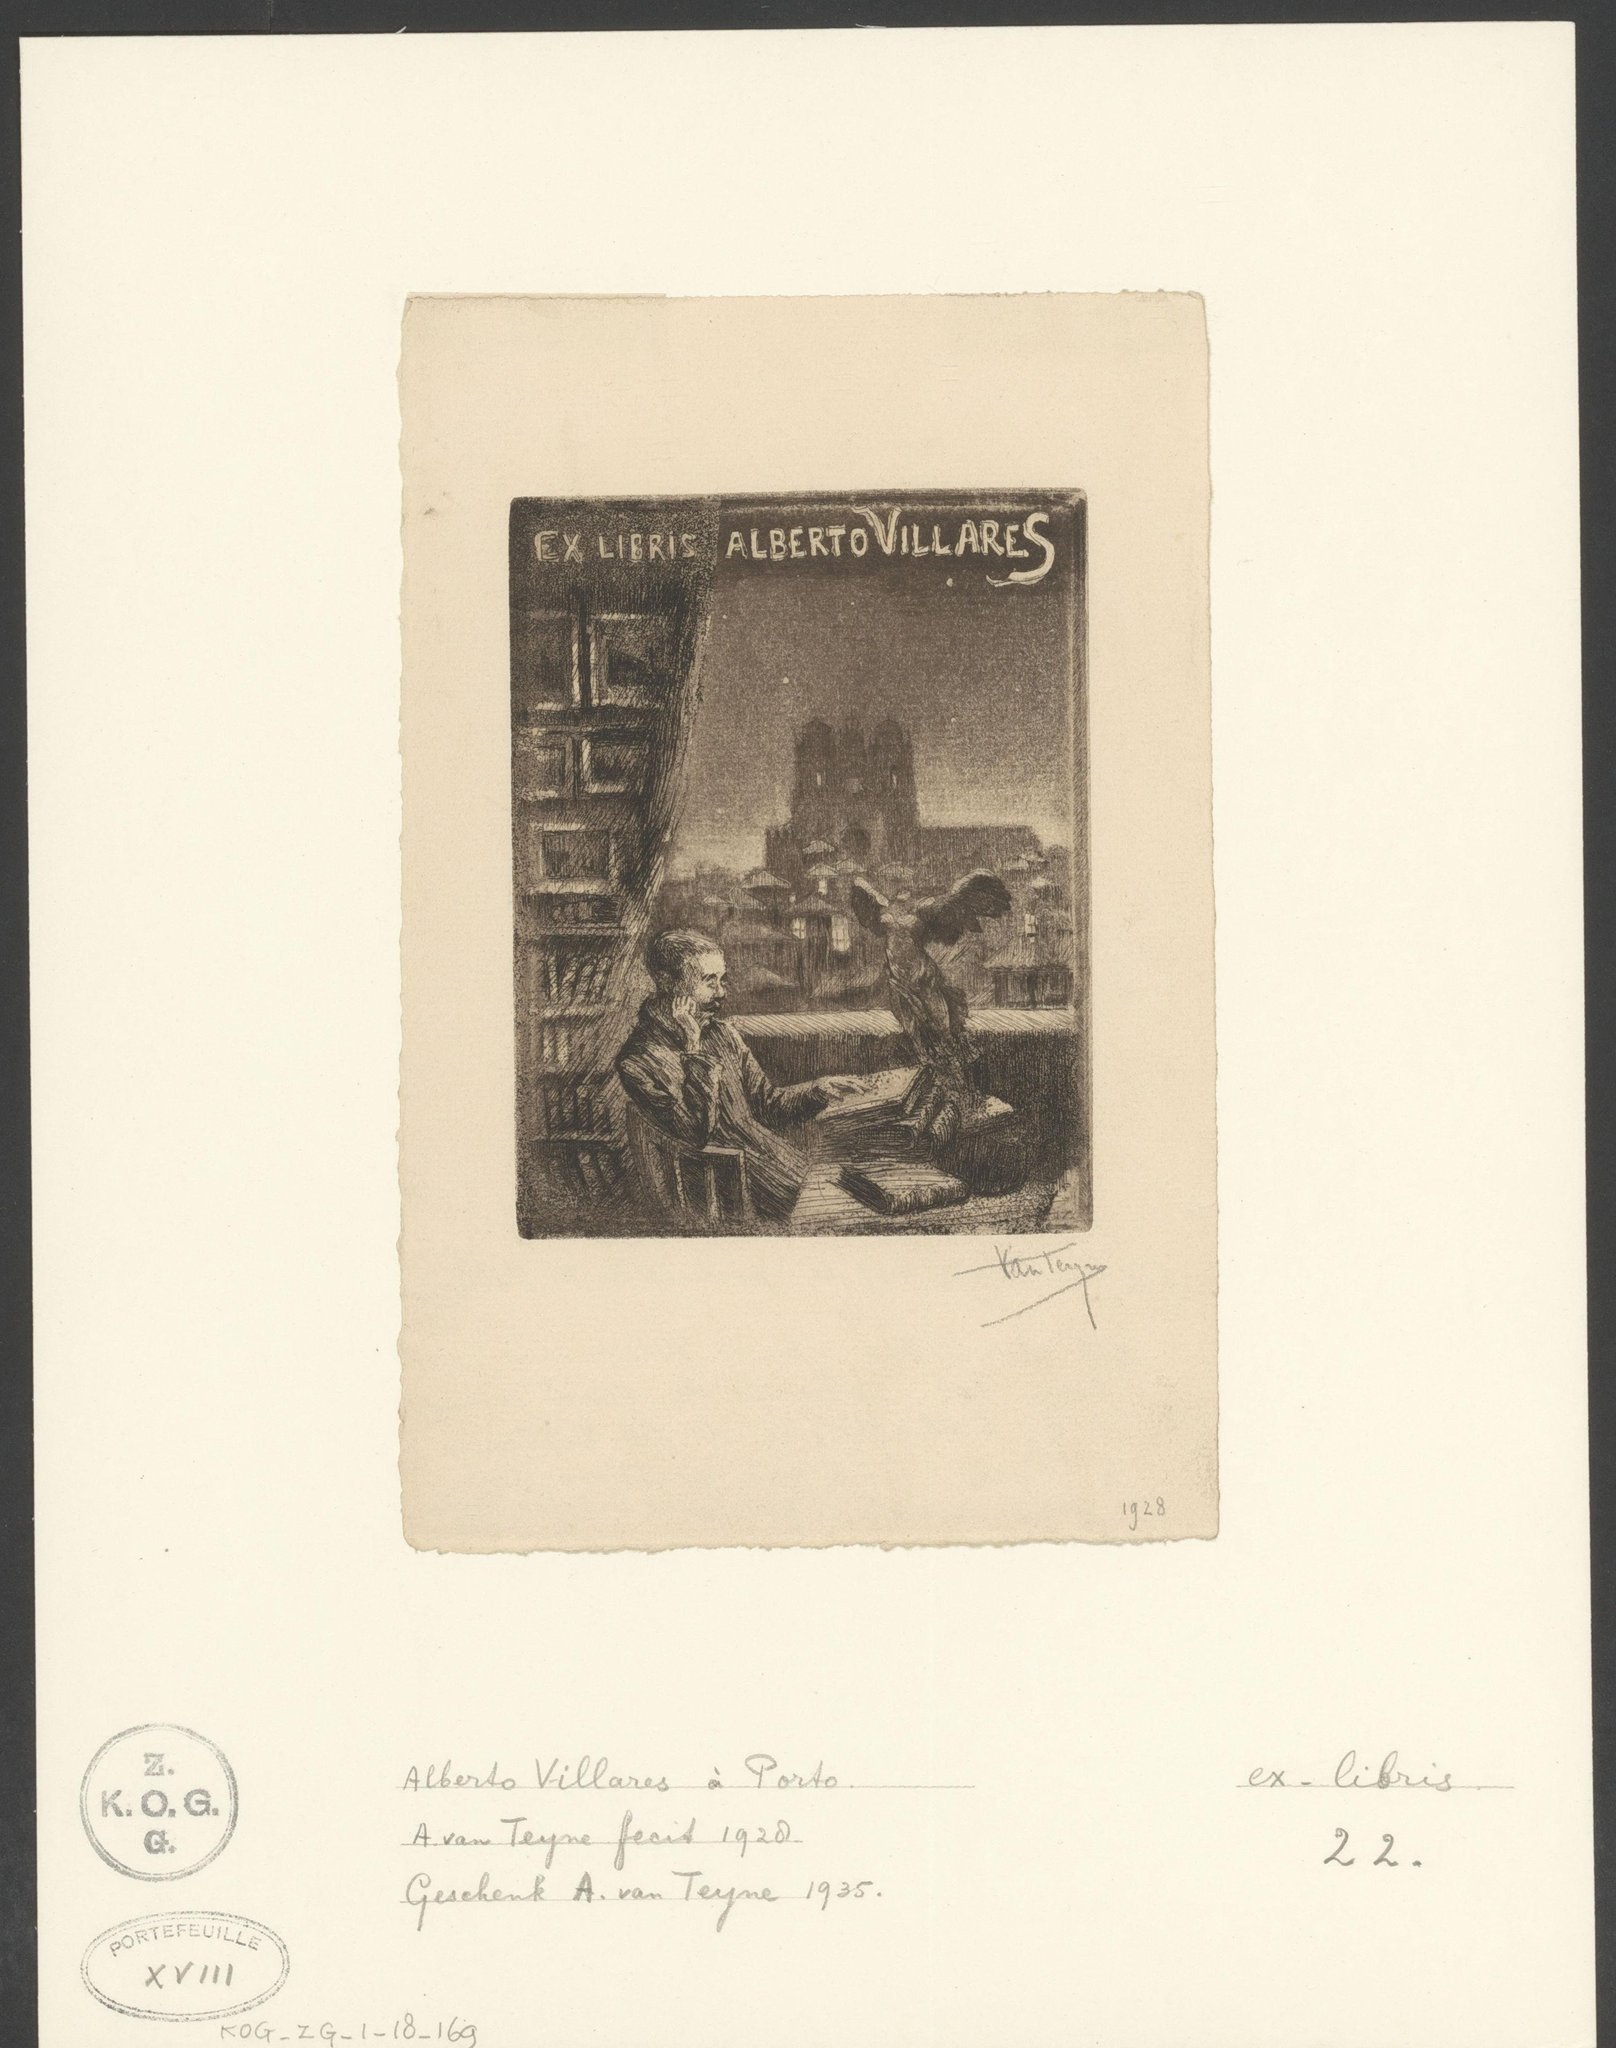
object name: bookplate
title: Ex libris van Alberto Villares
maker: anthonie van teijn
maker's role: draughtsman, painter, print maker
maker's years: 1863-1943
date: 1928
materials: paper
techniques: aquatint, etching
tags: bookshelves, castle, ex-libris, sculpture, sitting on an elevation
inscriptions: collector's mark: Lugt 1641, stamp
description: Onderwerpsrubrieken binnen de Atlas Zeden en Gewoonten: Schoone kunsten, Ex-libris en gelegenheidsgrafiek.